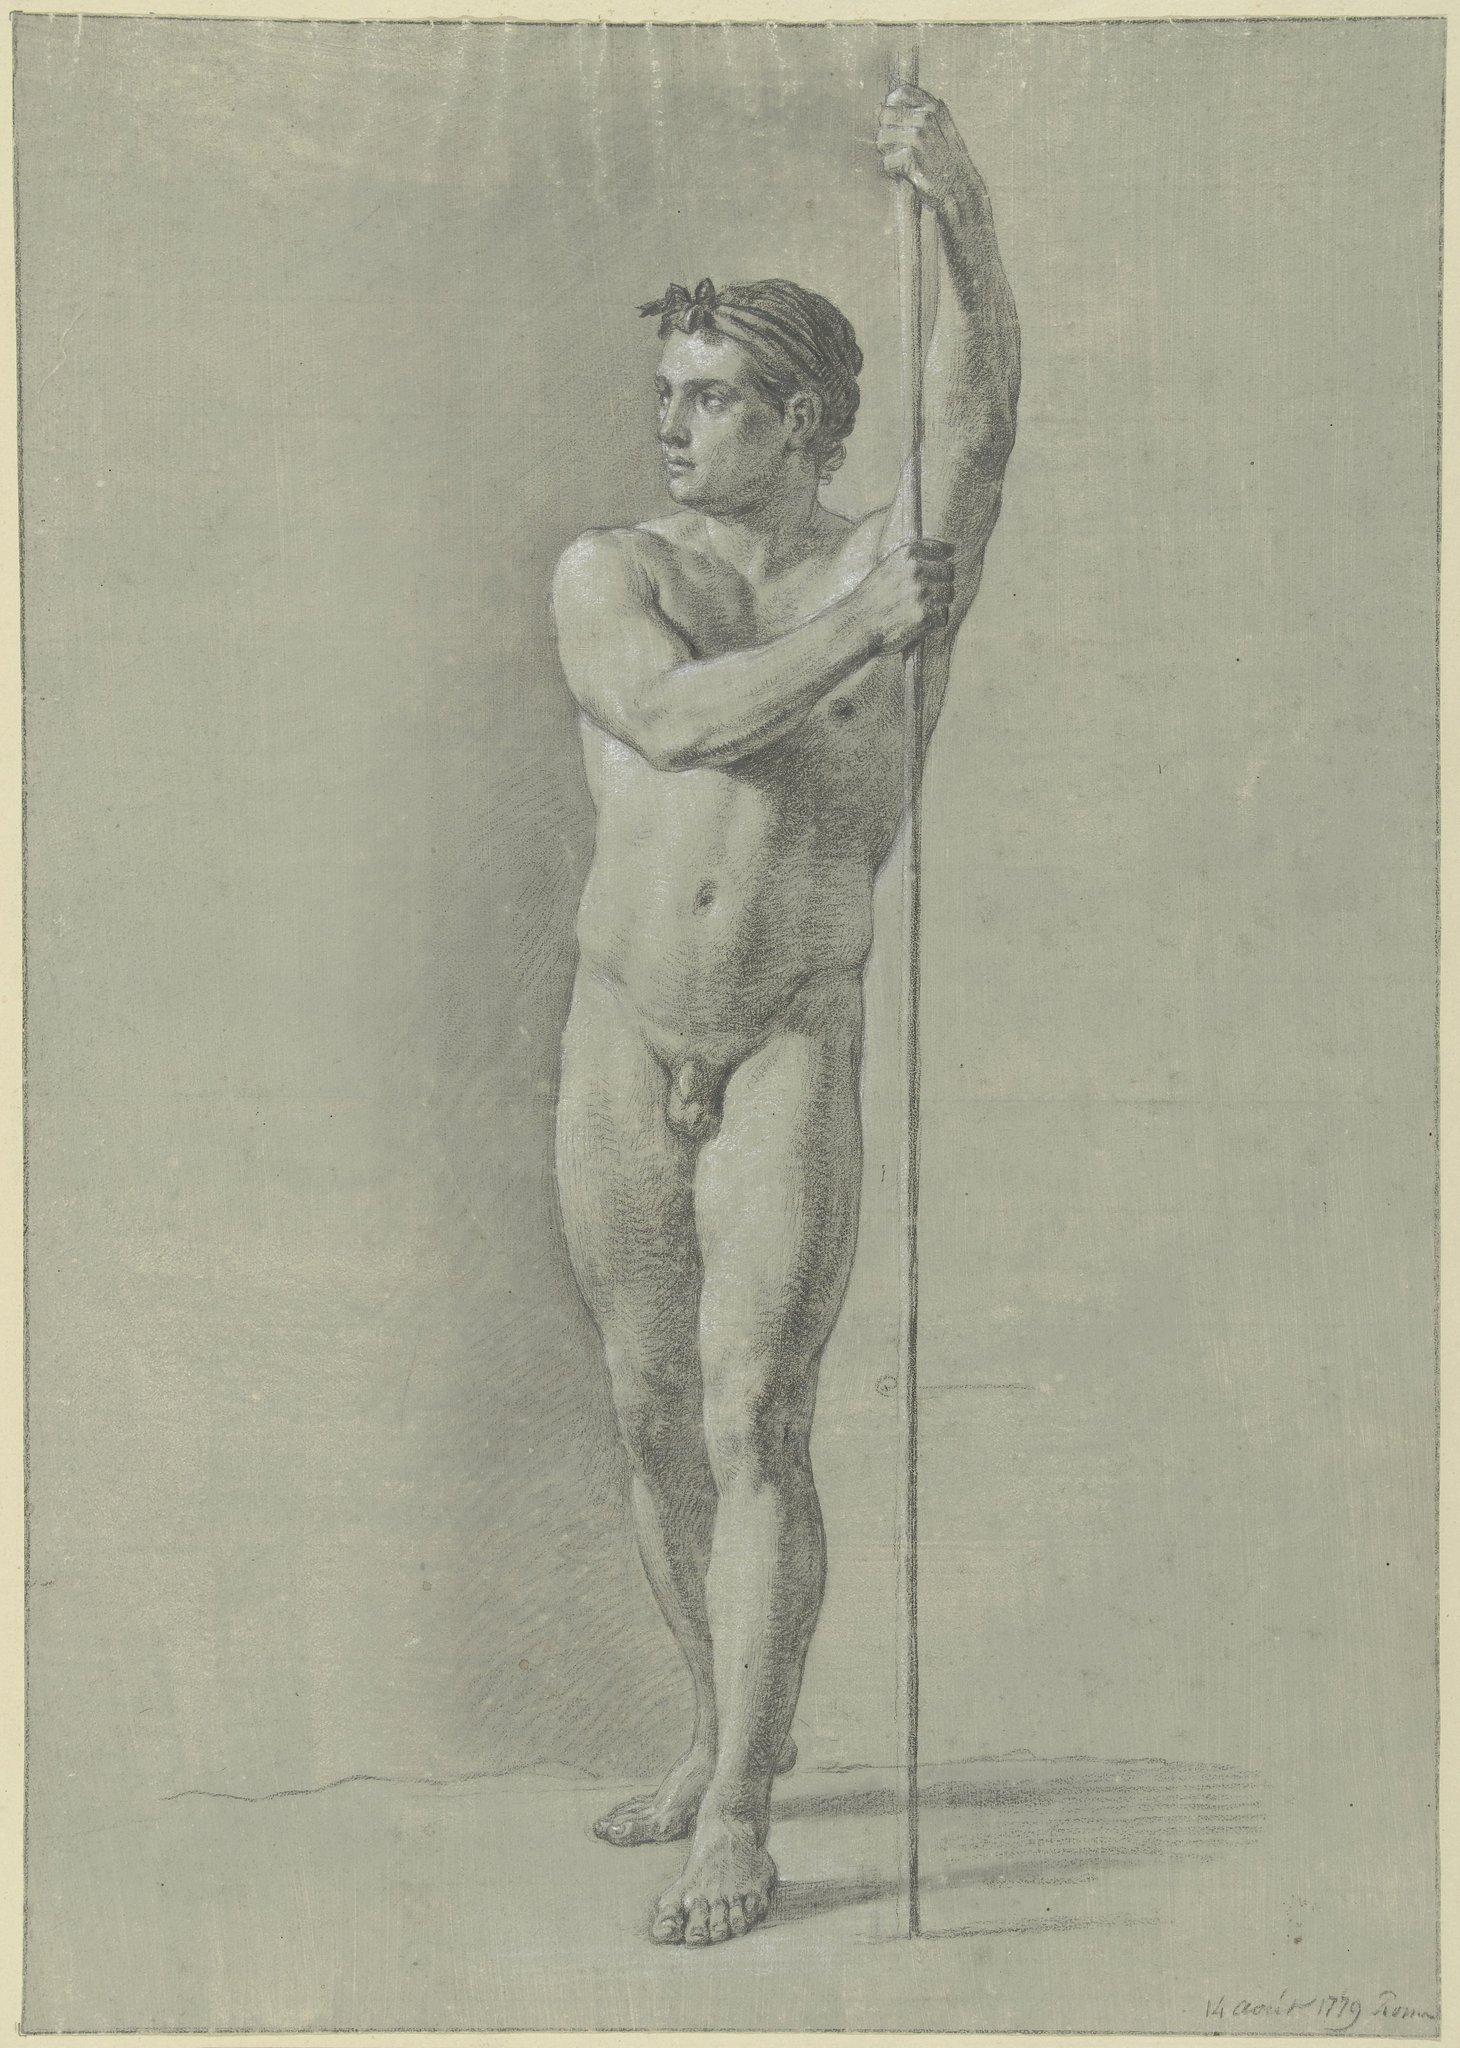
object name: drawing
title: Staand mannelijk naakt met een stok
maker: jean grandjean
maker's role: draughtsman, print maker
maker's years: 1752-1781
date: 1779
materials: chalk, paper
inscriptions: date: ‘14 aout 1779’